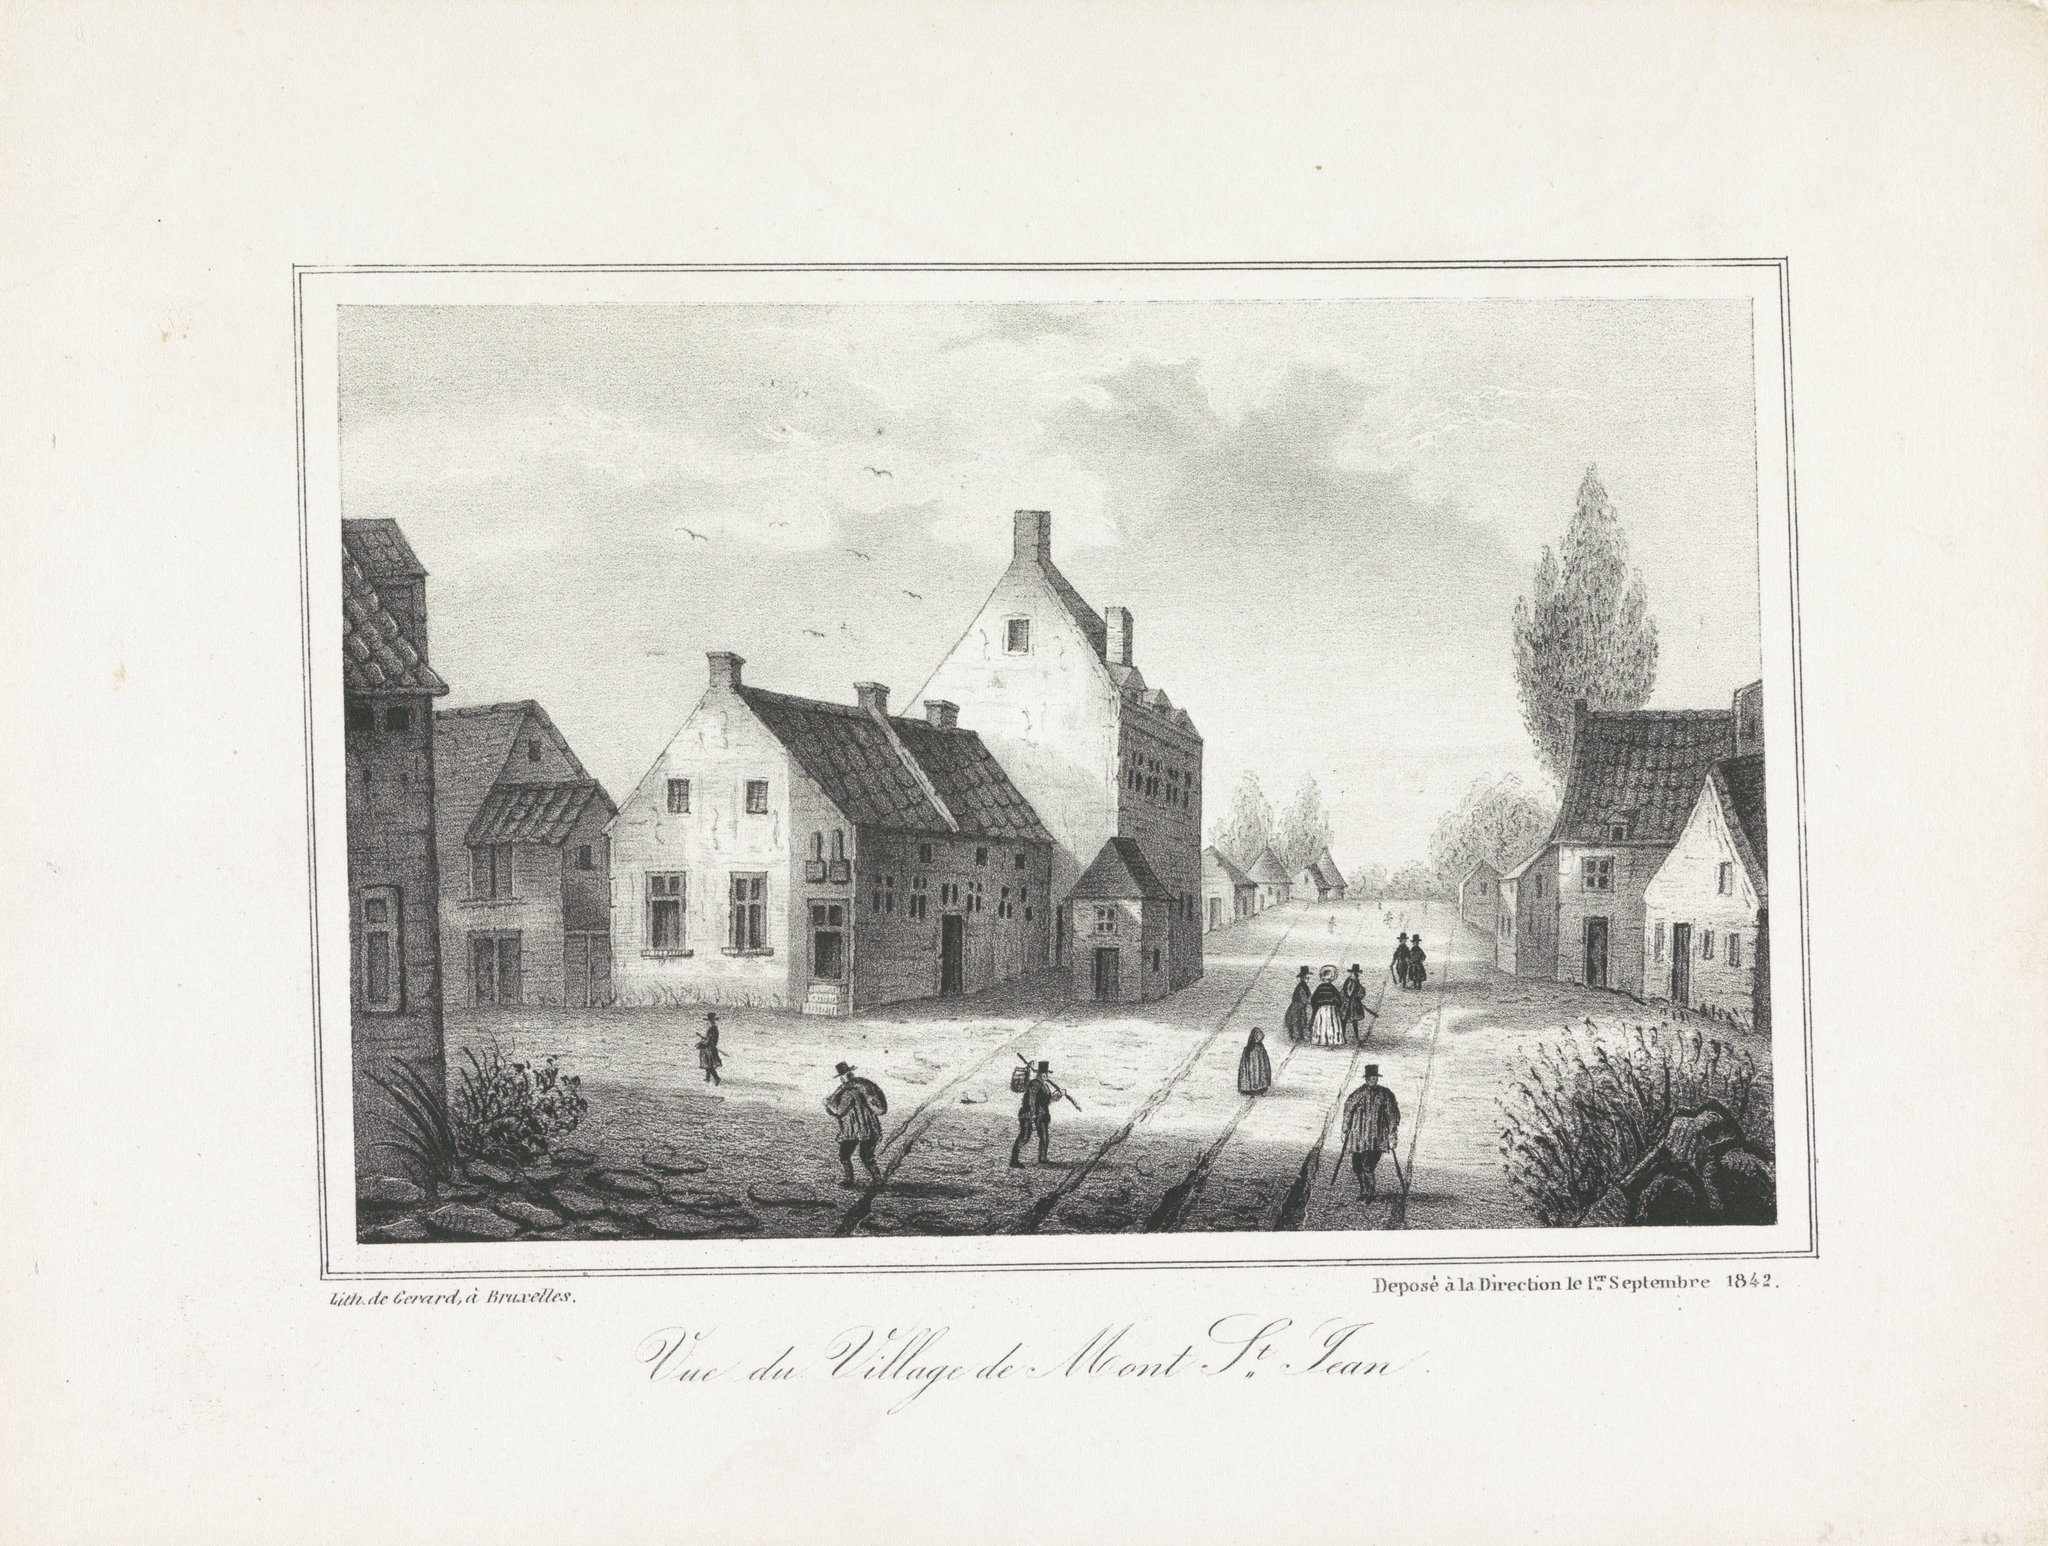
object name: print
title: Gezicht te Mont-Saint-Jean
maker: h. gérard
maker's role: printer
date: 1842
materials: paper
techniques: lithograph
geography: brussels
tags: waterloo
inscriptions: collector's mark: Lugt 2228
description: Gezicht in een straat te Mont-Saint-Jean, een dorpje nabij Waterloo. Onderdeel van een serie van twaalf platen (aangevuld tot veertien) met gezichten uit ca. 1840 van de omgeving waar de slag bij Waterloo plaatsvond op 18 juni 1815.